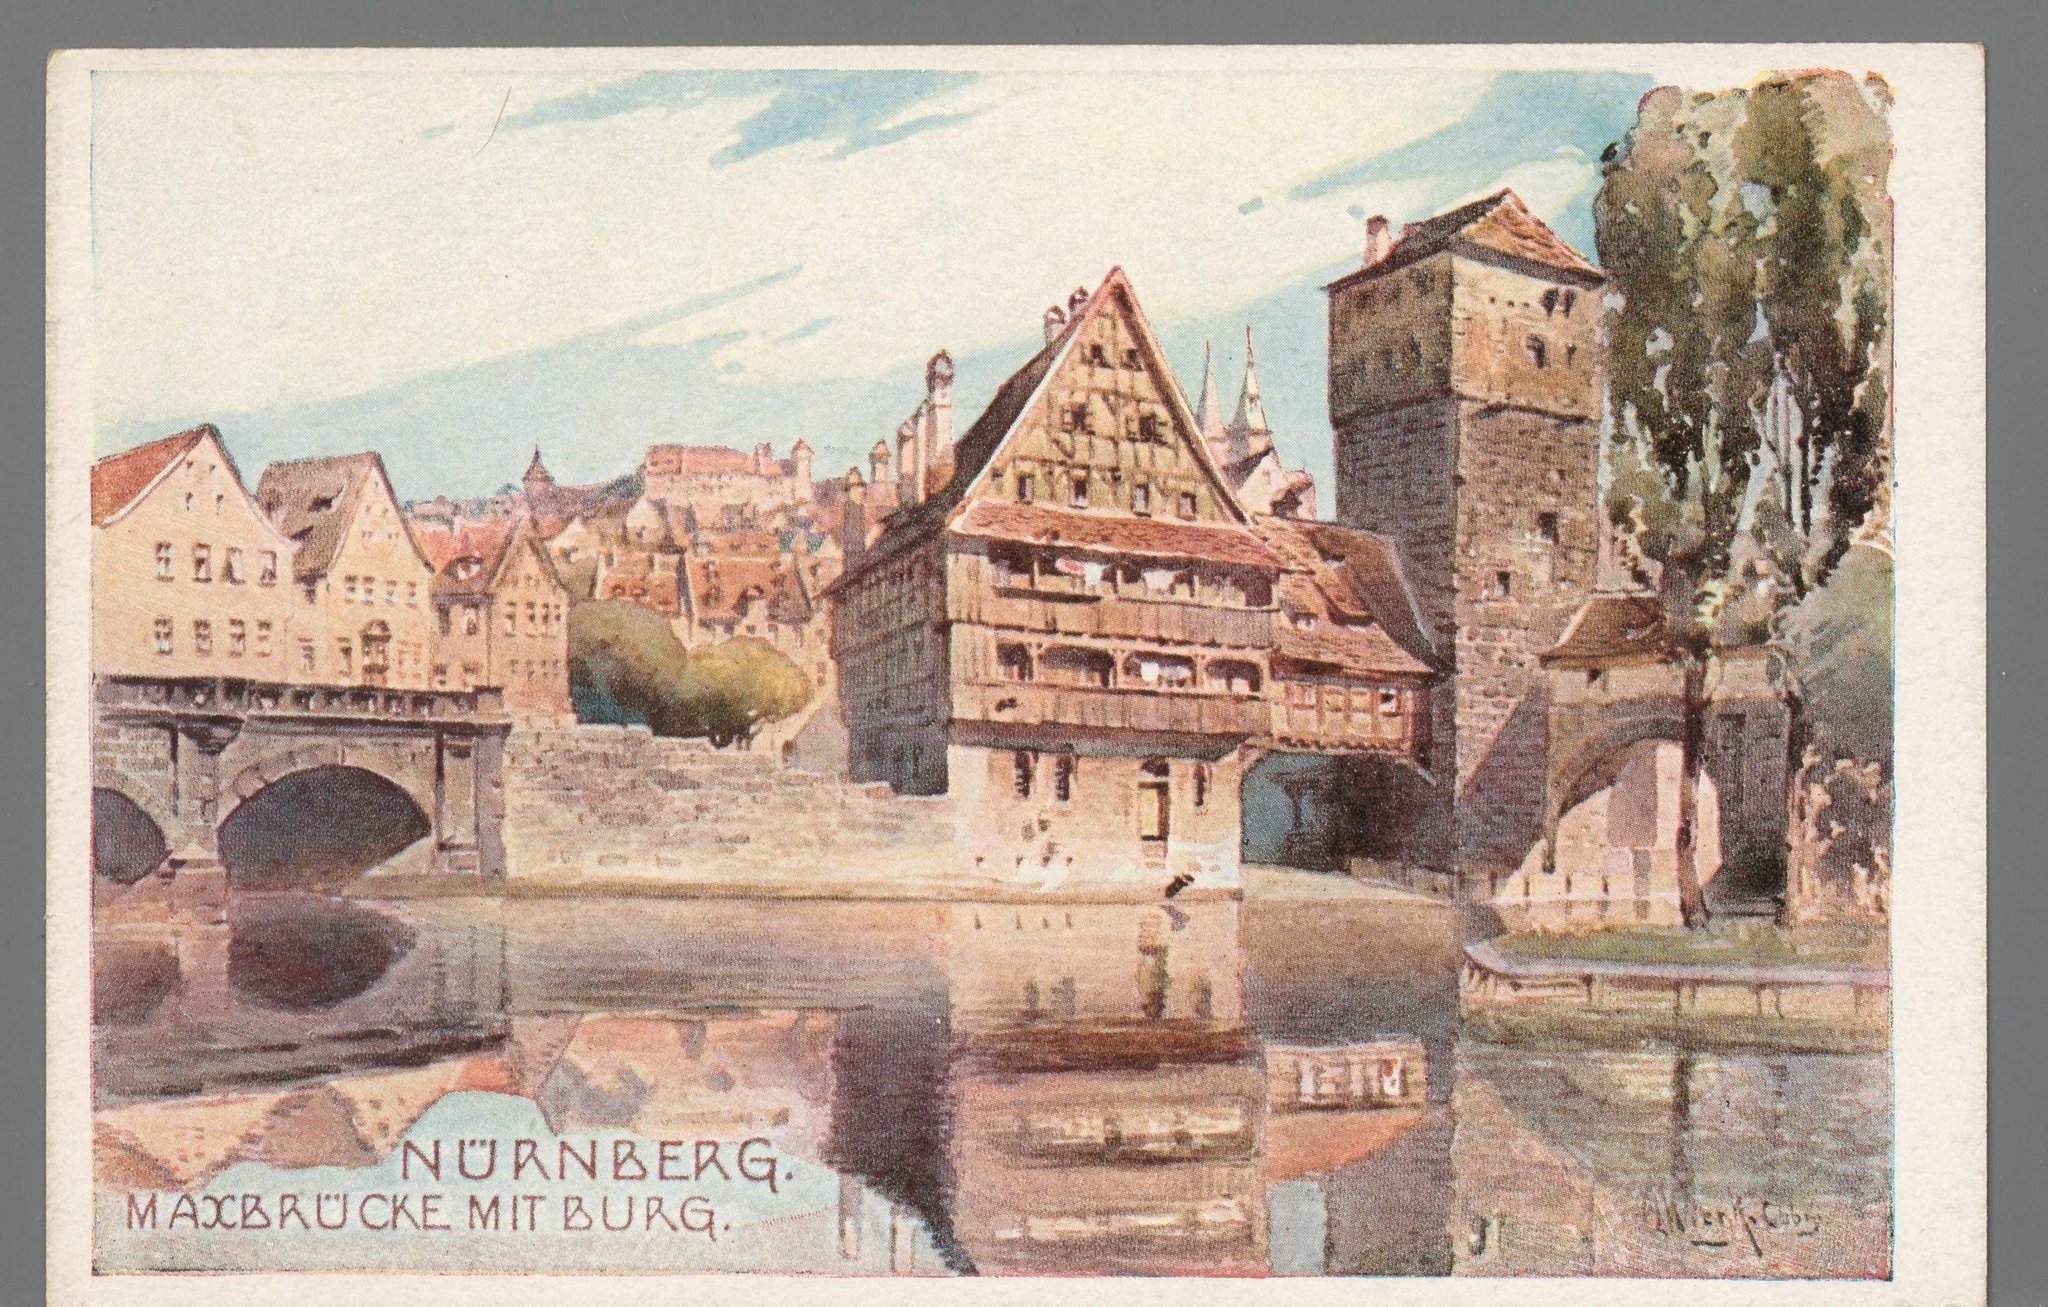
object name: photomechanical print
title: Nürnberg. Maxbrücke mit Burg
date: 1905-1930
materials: cardboard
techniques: color autotype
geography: nuremberg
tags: castle, canals, waters (in city), bridge in city across river, canal, etc.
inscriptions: inscription: ‘J Wien K’